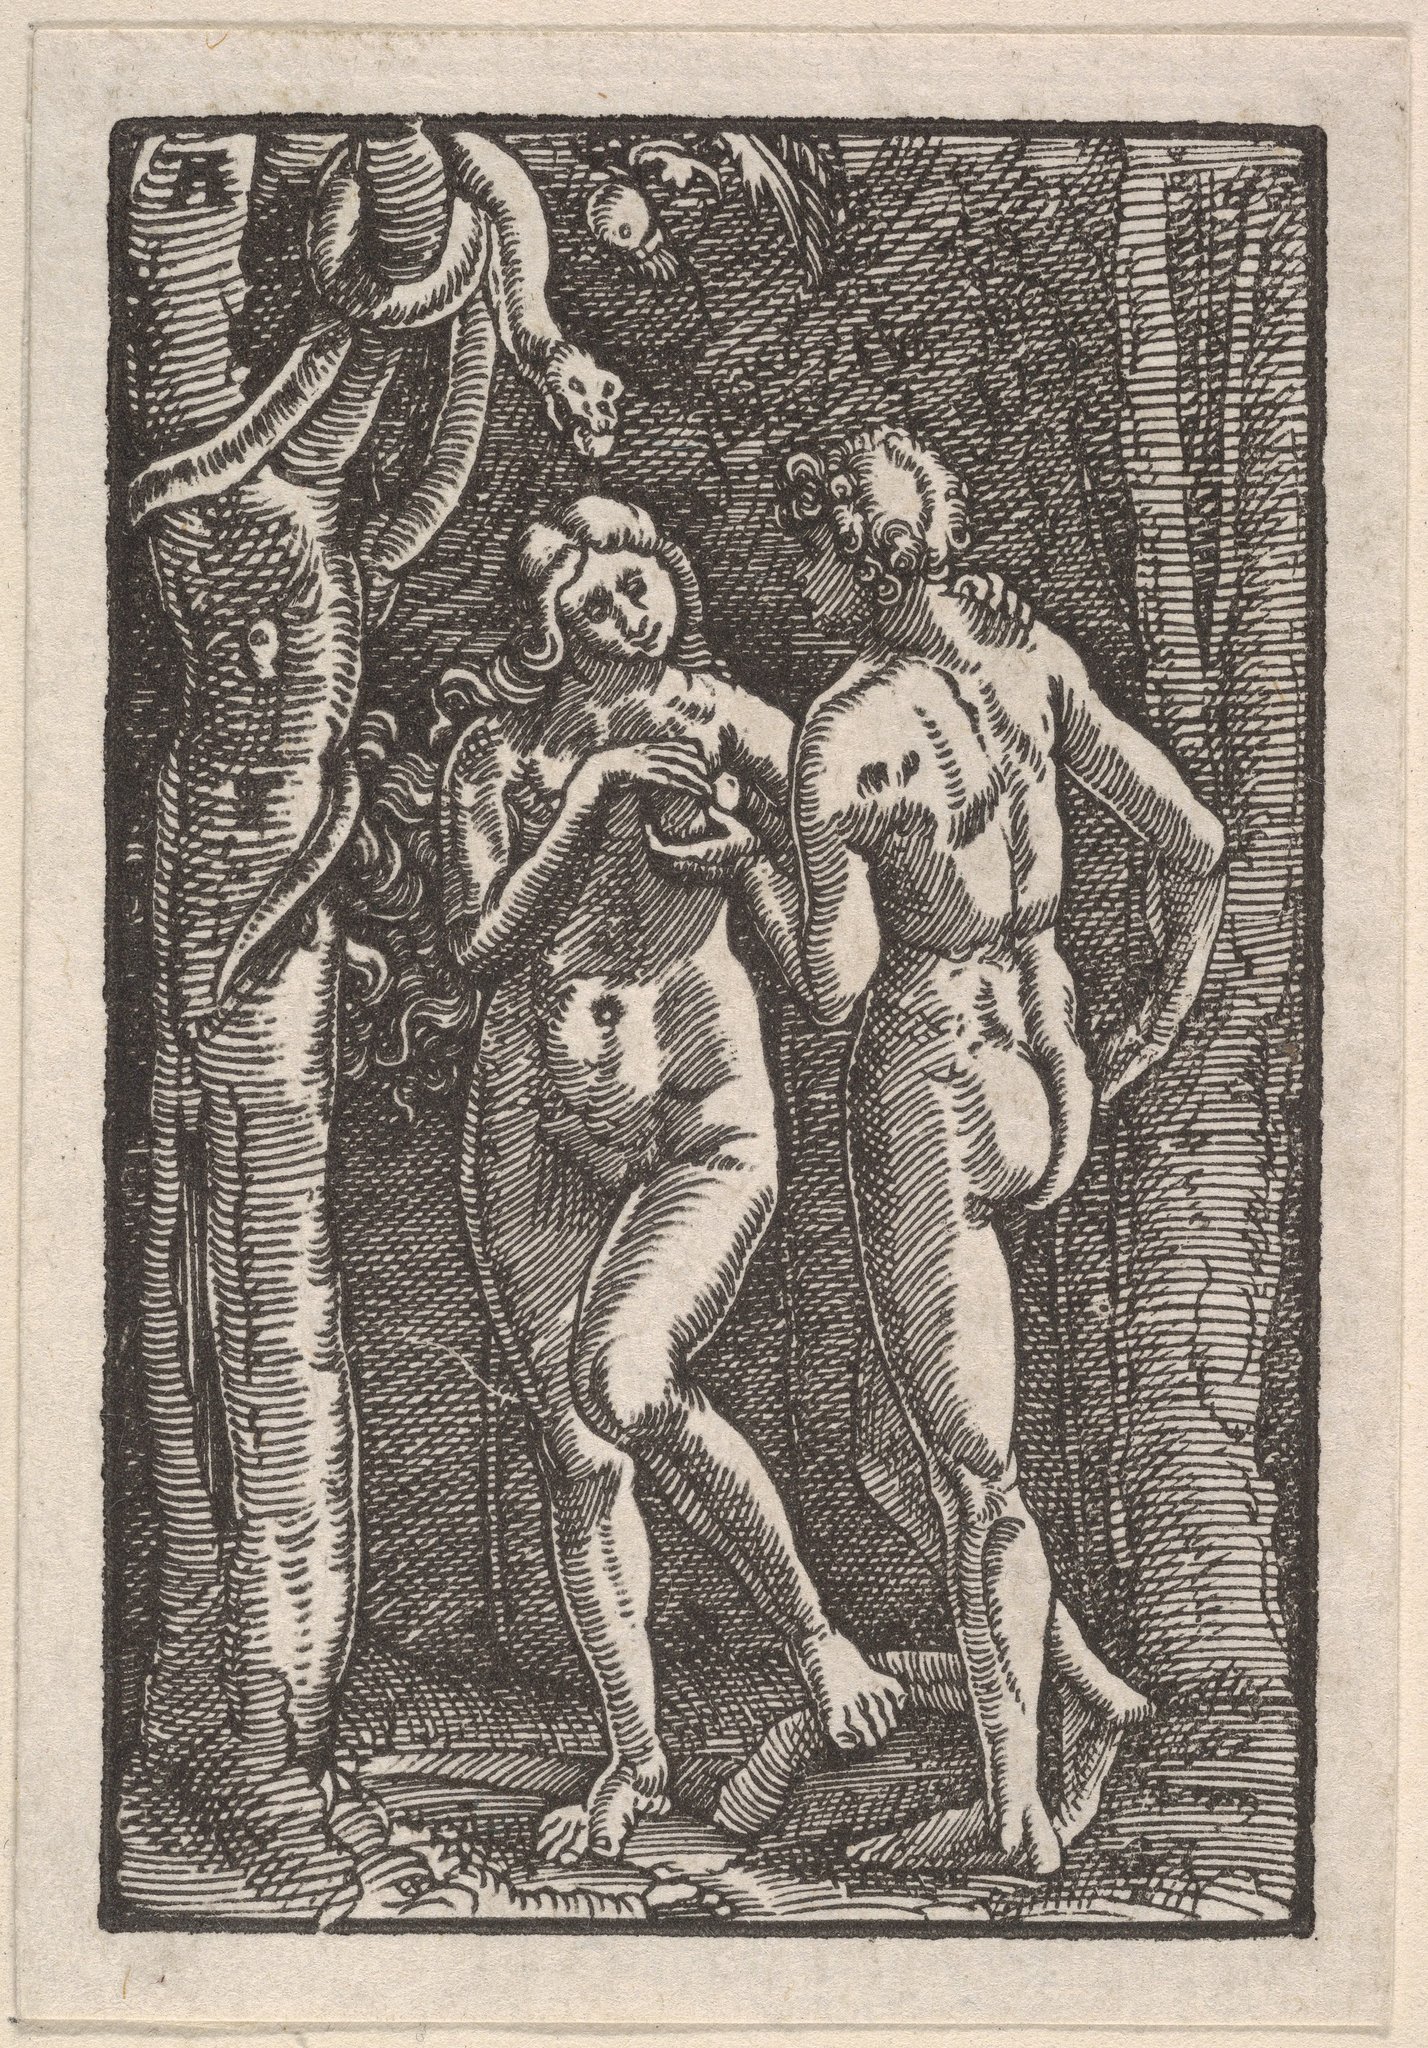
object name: print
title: The Fall of Man, from "The Fall and Salvation of Mankind Through the Life and Passion of Christ"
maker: albrecht altdorfer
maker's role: artist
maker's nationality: german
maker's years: 1480-1538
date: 1513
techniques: woodcut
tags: snakes,adam,eve